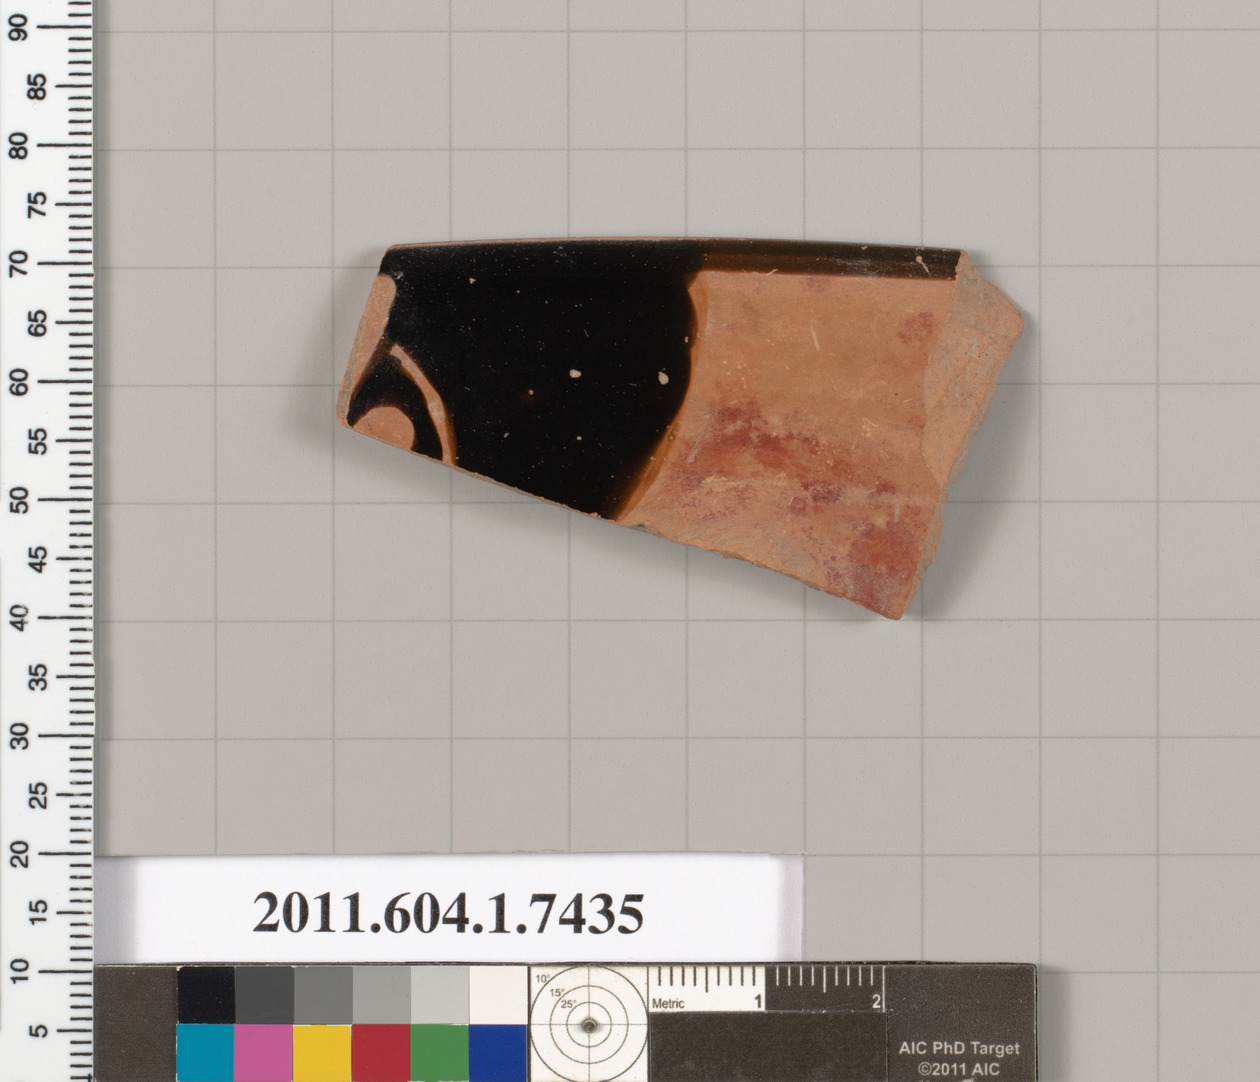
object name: kylix fragment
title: Terracotta rim fragment of a kylix (drinking cup)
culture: greek, attic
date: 490-470 BCE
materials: terracotta